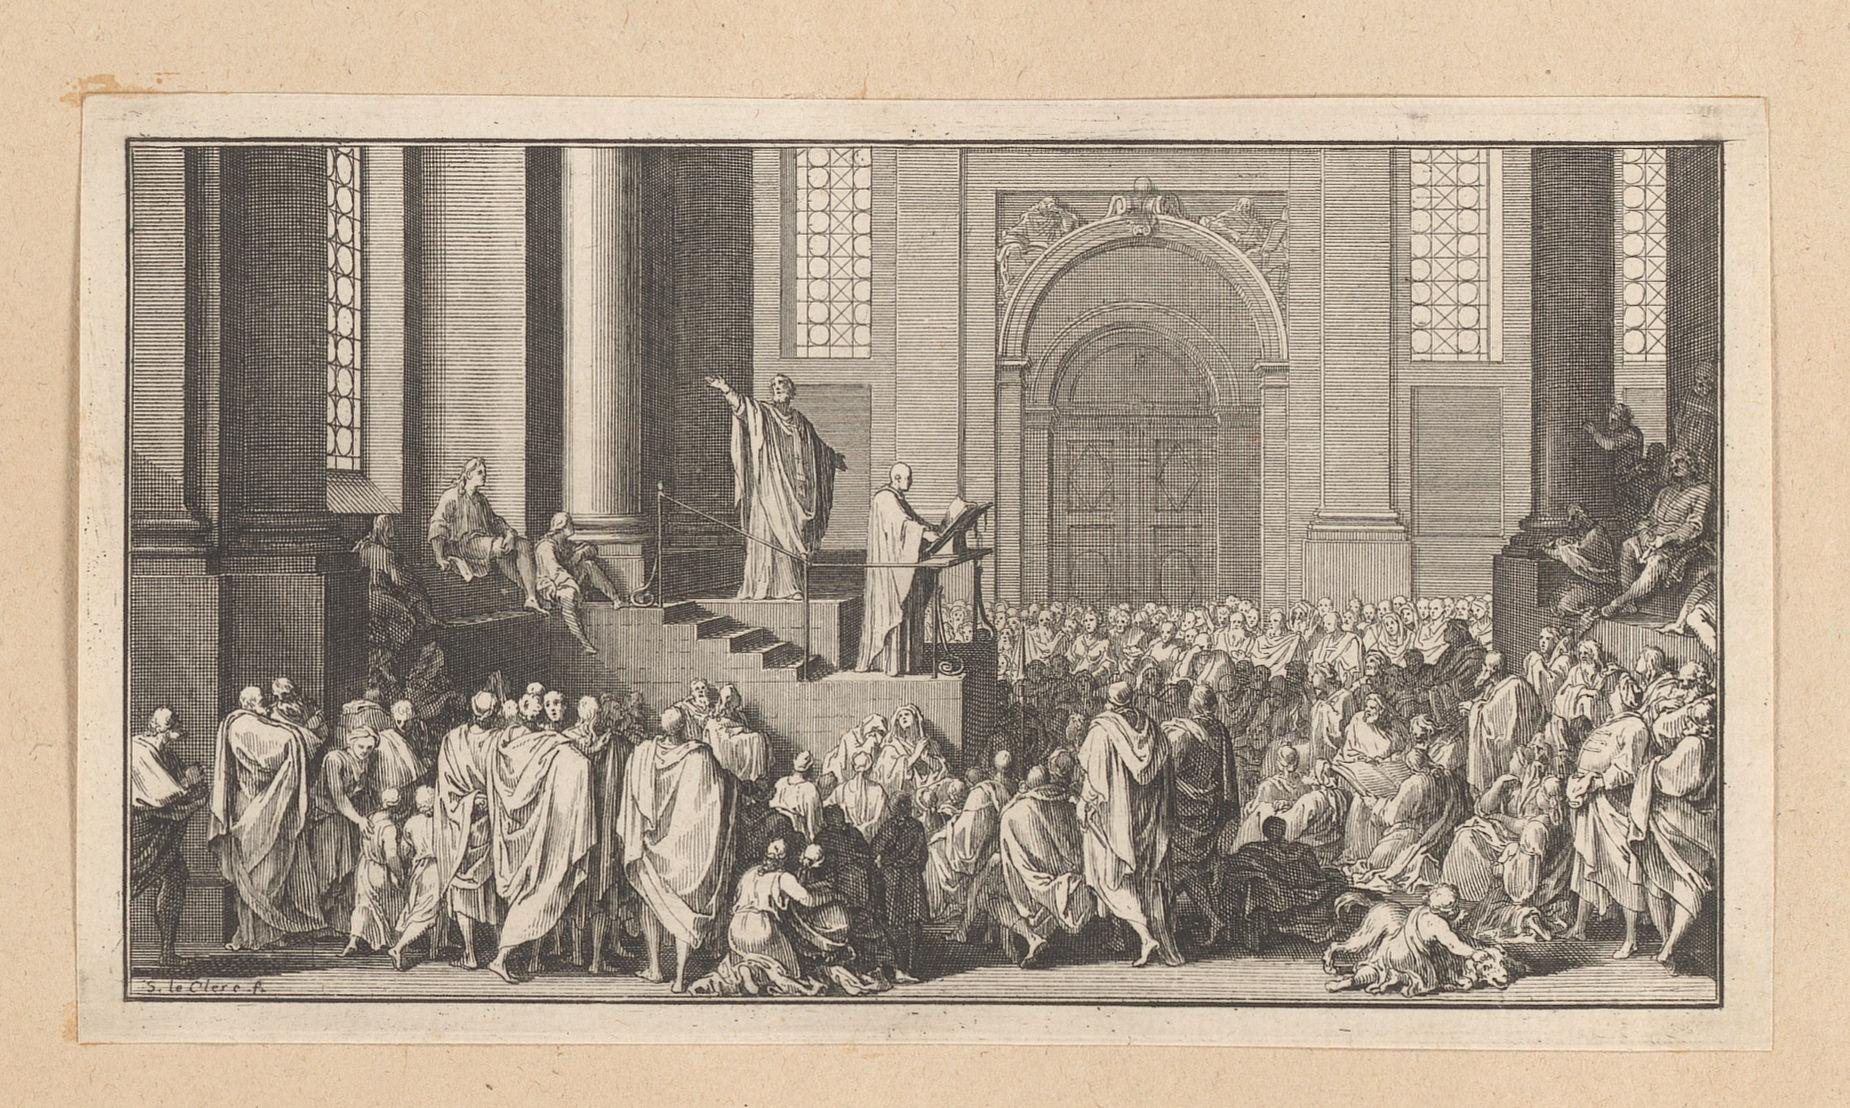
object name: album leaf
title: Augustinus van Hippo loopt de trap van een kerk af voor een groep mensen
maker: sébastien leclerc (i)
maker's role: print maker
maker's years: 1637-1714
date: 1647-1714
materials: paper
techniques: etching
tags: augustine, bishop of hippo; possible attributes: arrows piercing his breast, book, child with spoon, flaming heart, heart (pierced with arrows), pen